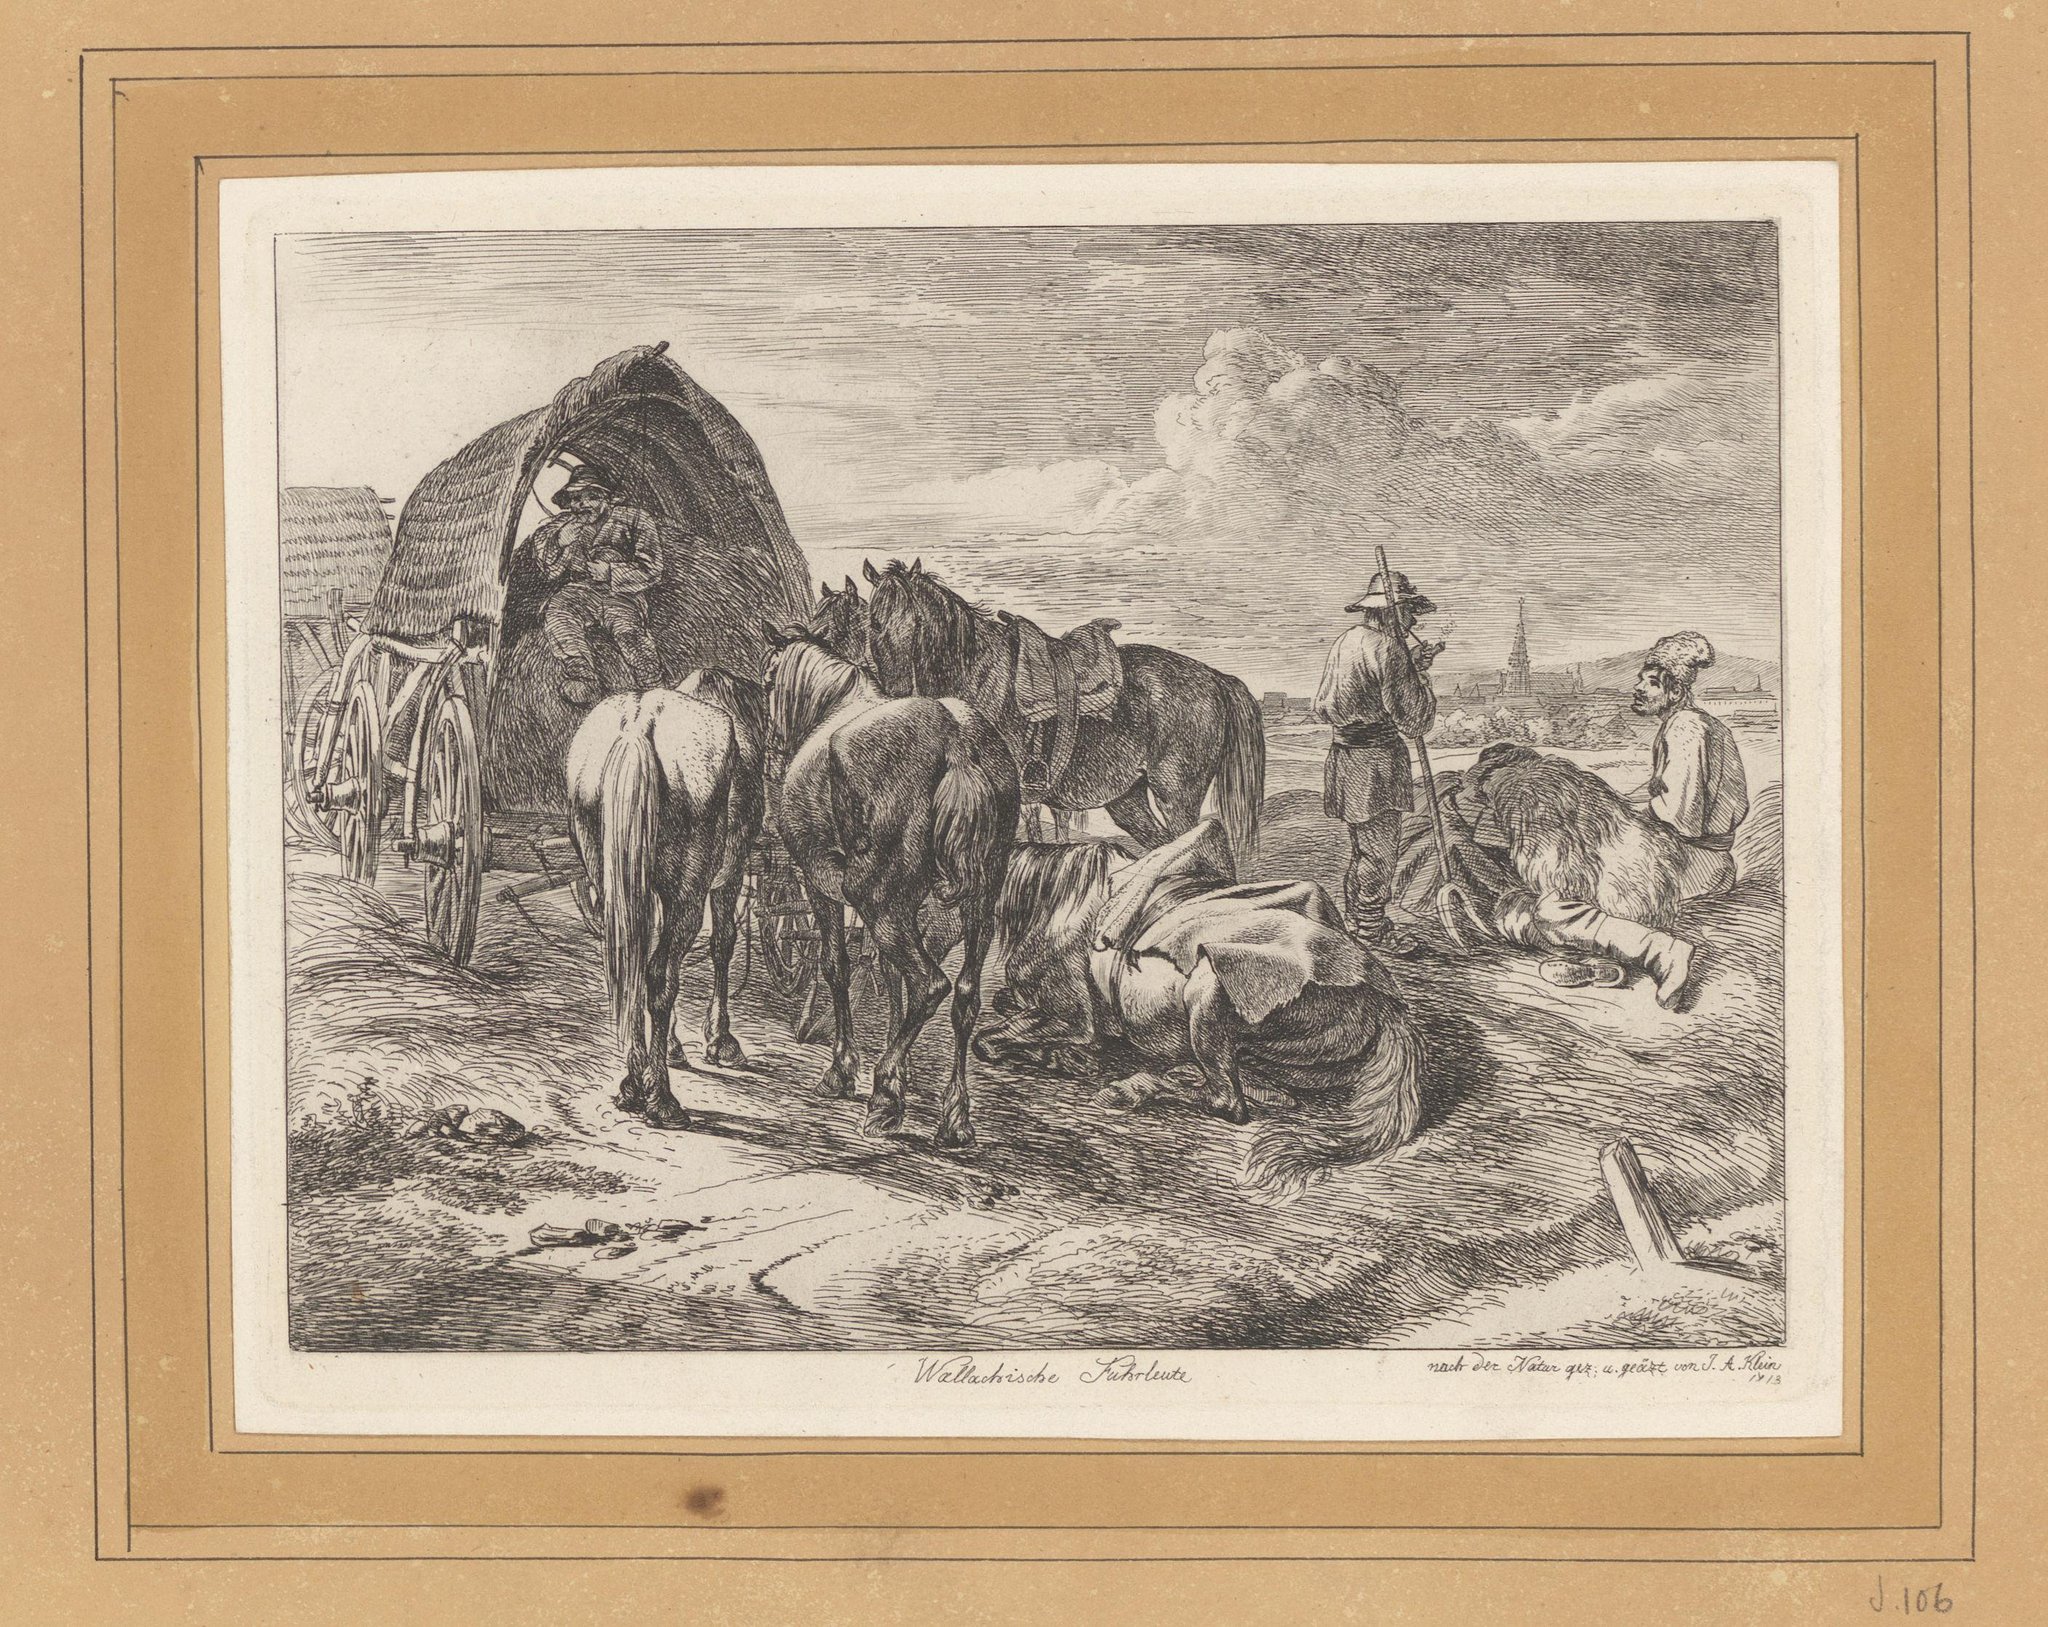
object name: print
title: Wallachische Fuhrleute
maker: johann adam klein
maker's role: draughtsman, print maker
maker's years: 1792-1875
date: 1813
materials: paper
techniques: etching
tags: (traveller) resting in the open air, hay-stack, hay-wagon, vienna state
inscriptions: collector's mark: Lugt 2228, : Lugt 2760